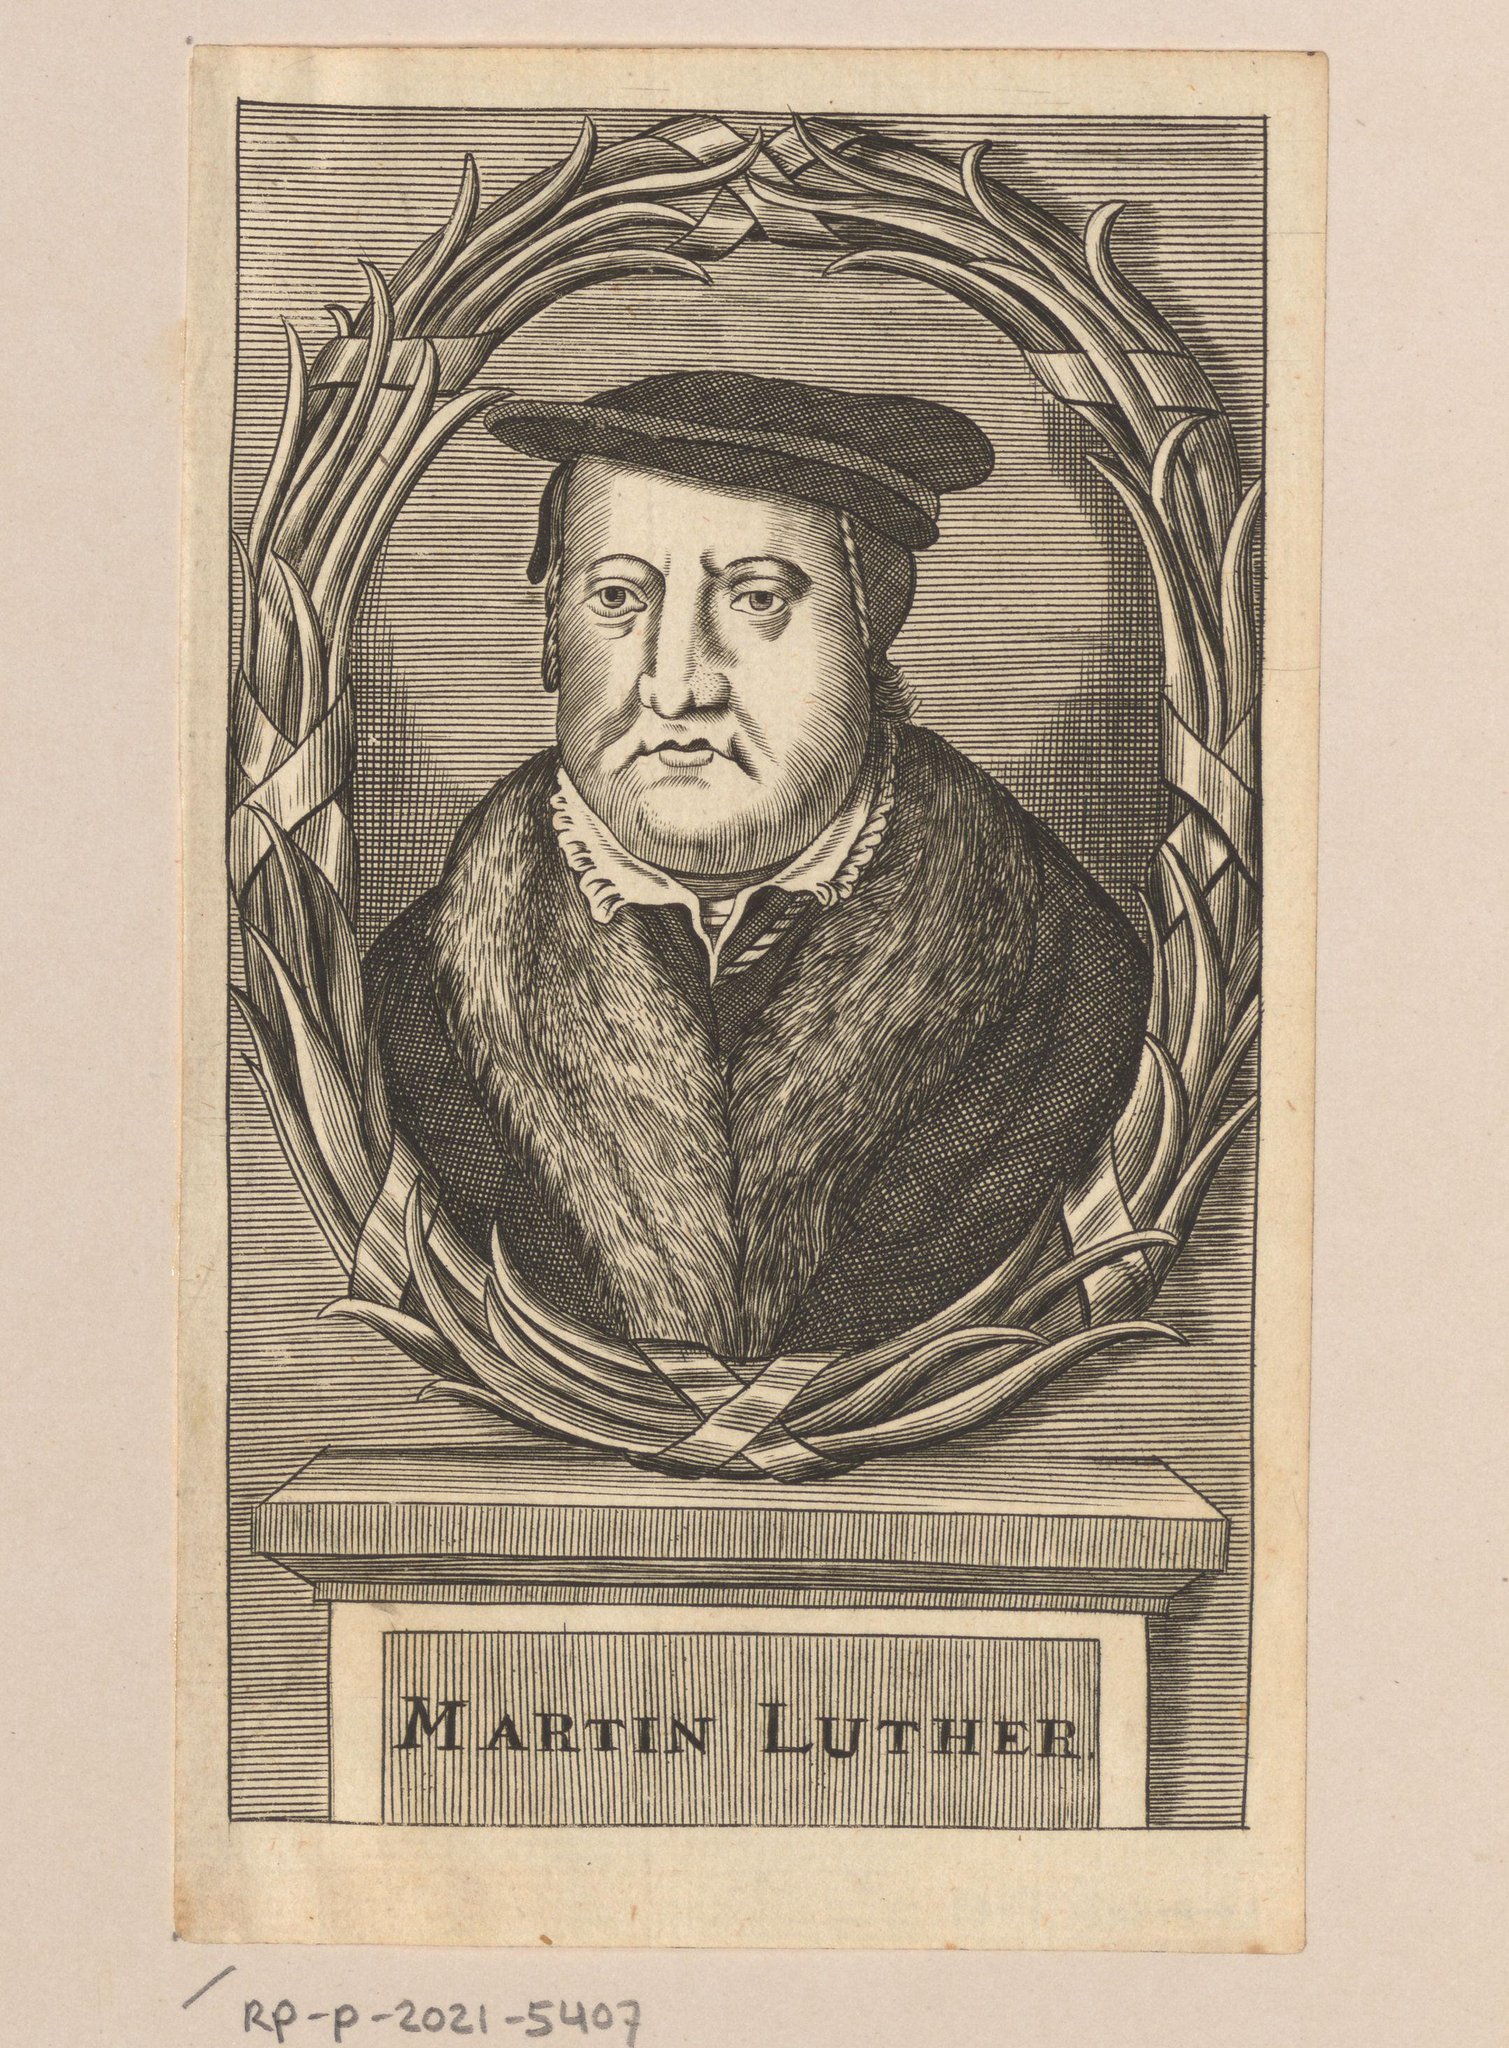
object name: print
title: Portret van Martin Luther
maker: Anonymous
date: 1650-1750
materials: paper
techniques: engraving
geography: germany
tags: priest, martin luther, theologian, ornament ~ medallion, historical persons